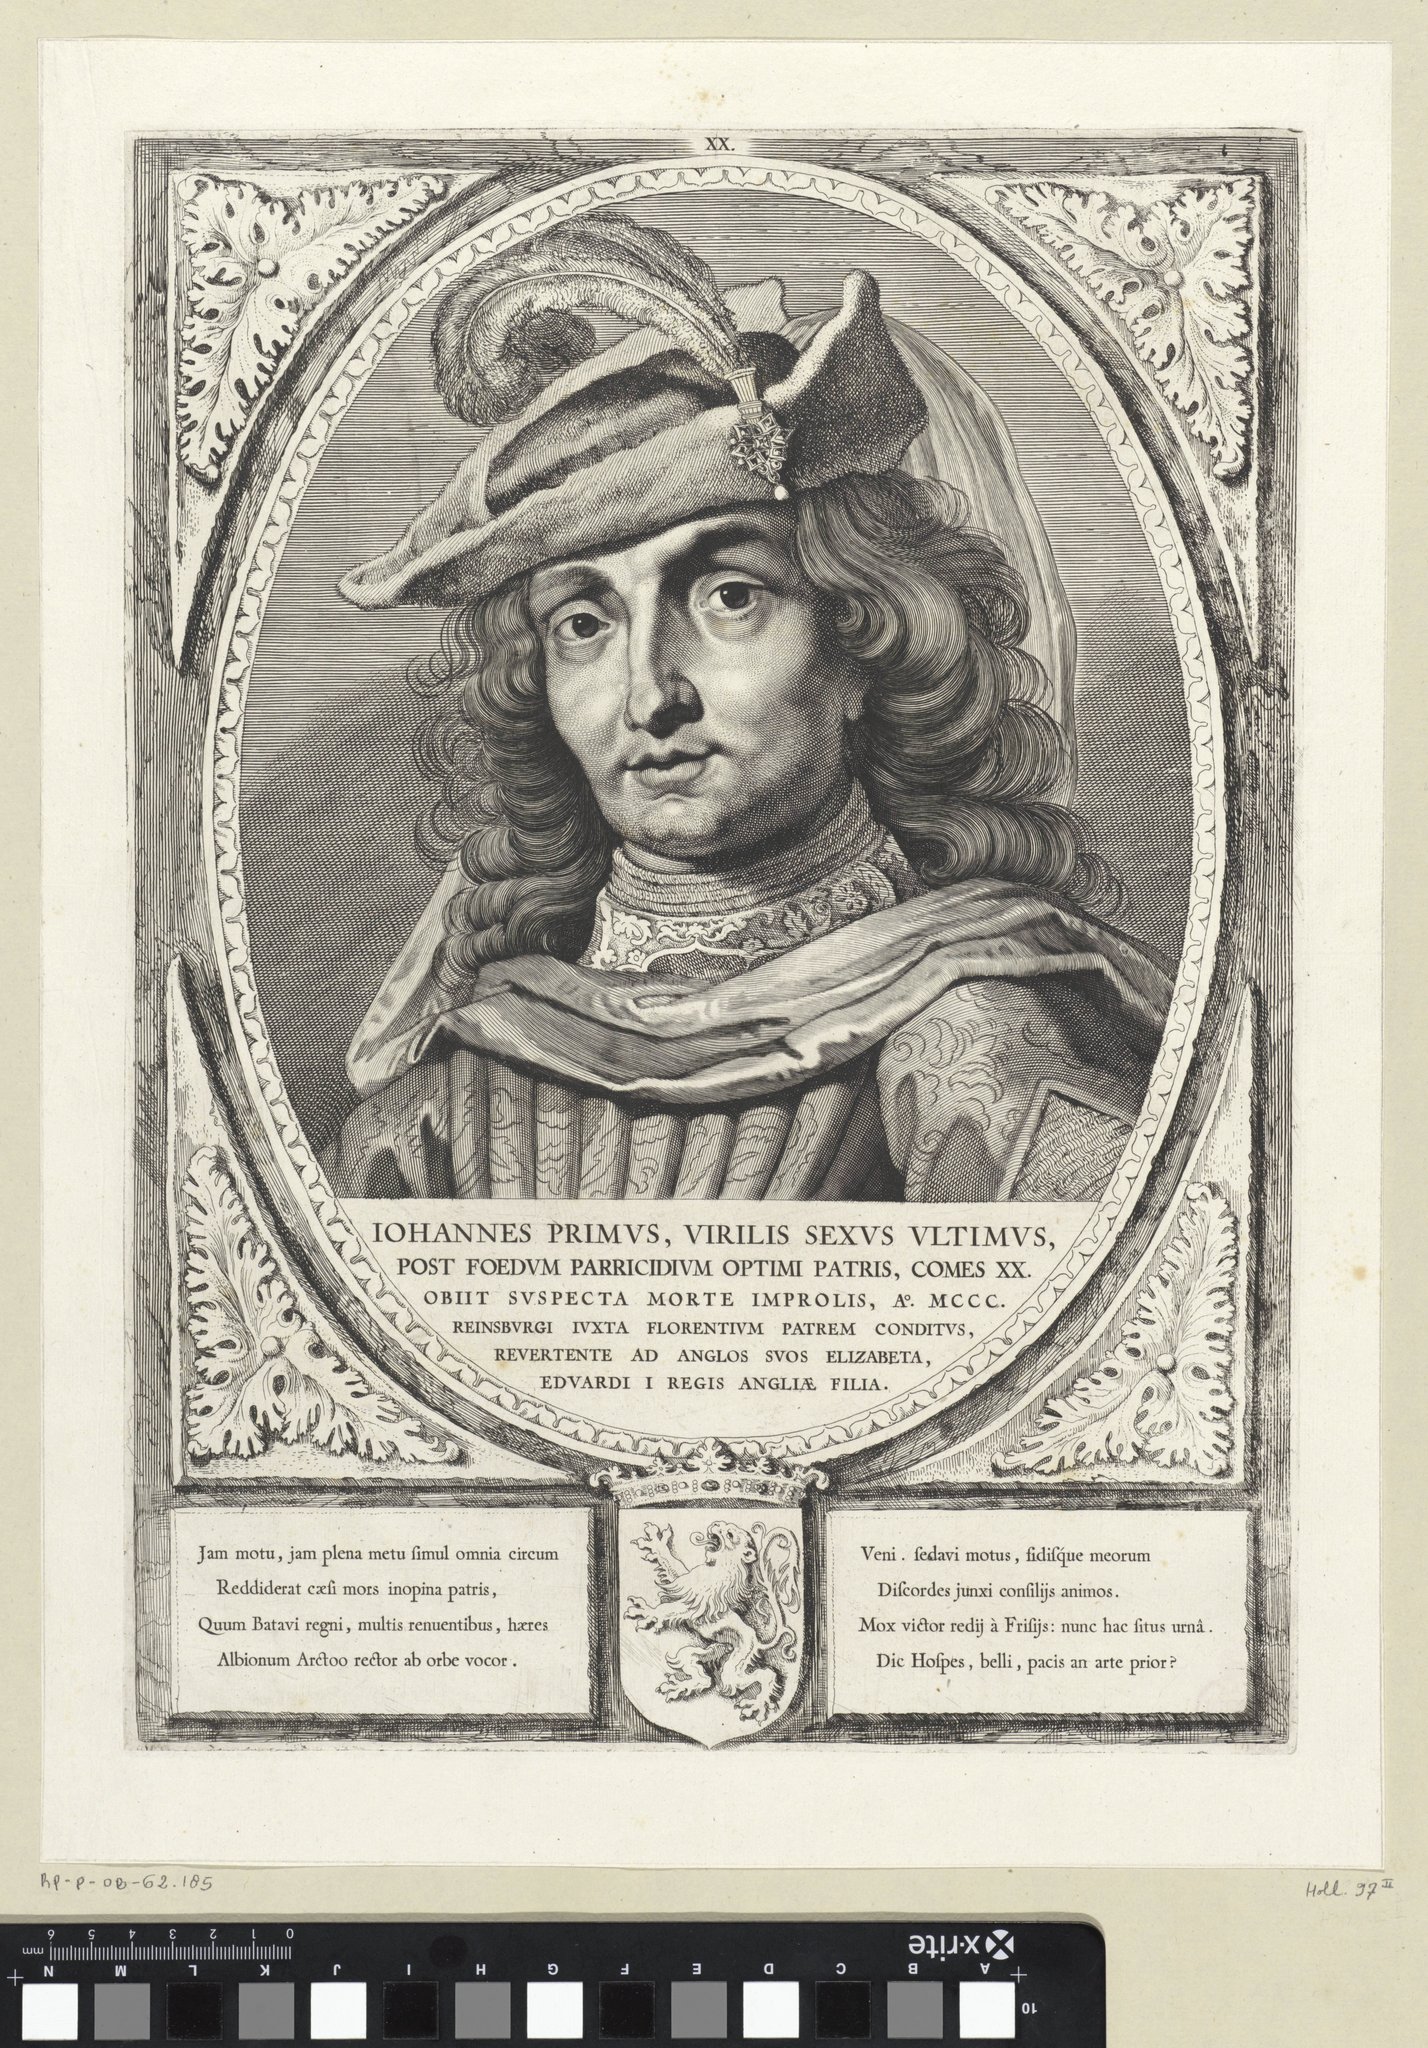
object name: print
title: Portret van Jan I, graaf van Holland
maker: cornelis visscher (ii)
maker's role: draughtsman, painter, print maker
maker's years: 1628-1658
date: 1650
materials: paper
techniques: engraving, etching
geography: haarlem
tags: jan i (graaf van holland)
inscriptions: collector's mark: Lugt 12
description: Proefdruk van de twintigste prent uit de serie 'Graven en gravinnen van Holland, Zeeland en West-Friesland', bestaande uit 38 prenten.